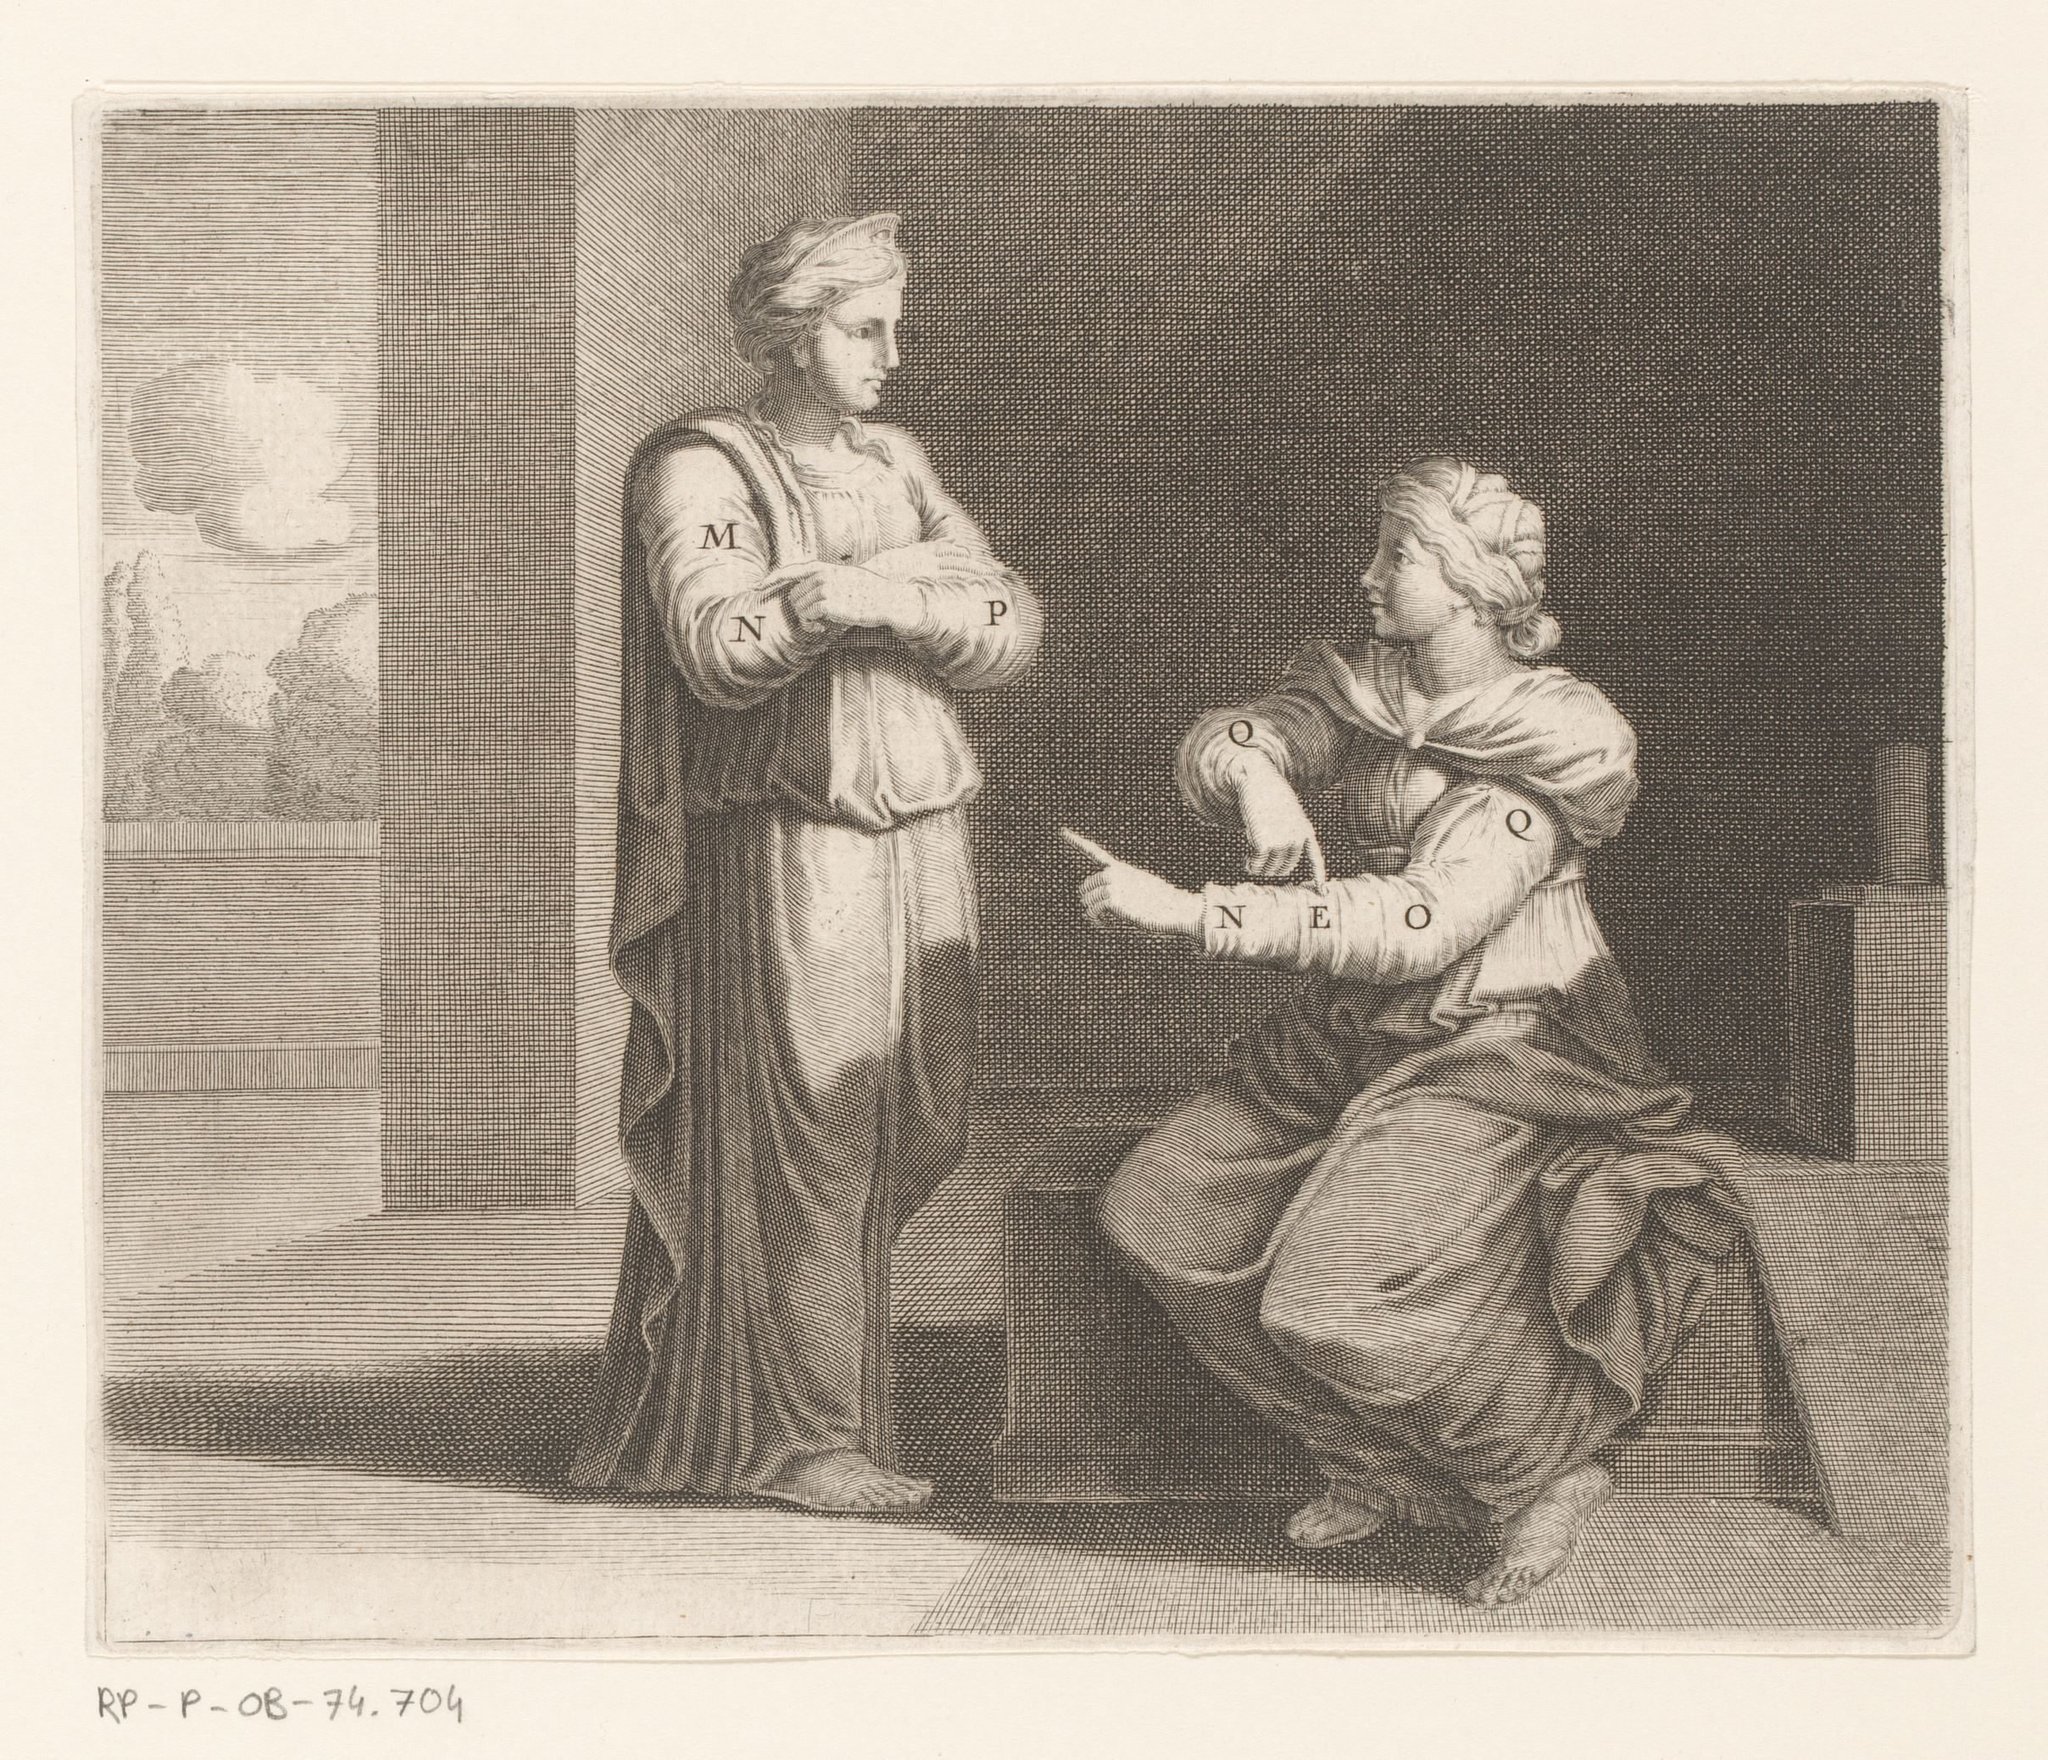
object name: print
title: Staande en zittende vrouw wijzen op delen van hun armen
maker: Anonymous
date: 1600-1699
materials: paper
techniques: engraving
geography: france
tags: sitting figure - aa - female human figure, arms, standing figure - aa - female human figure, conversation, dialogue; conversation piece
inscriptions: collector's mark: Lugt 2228